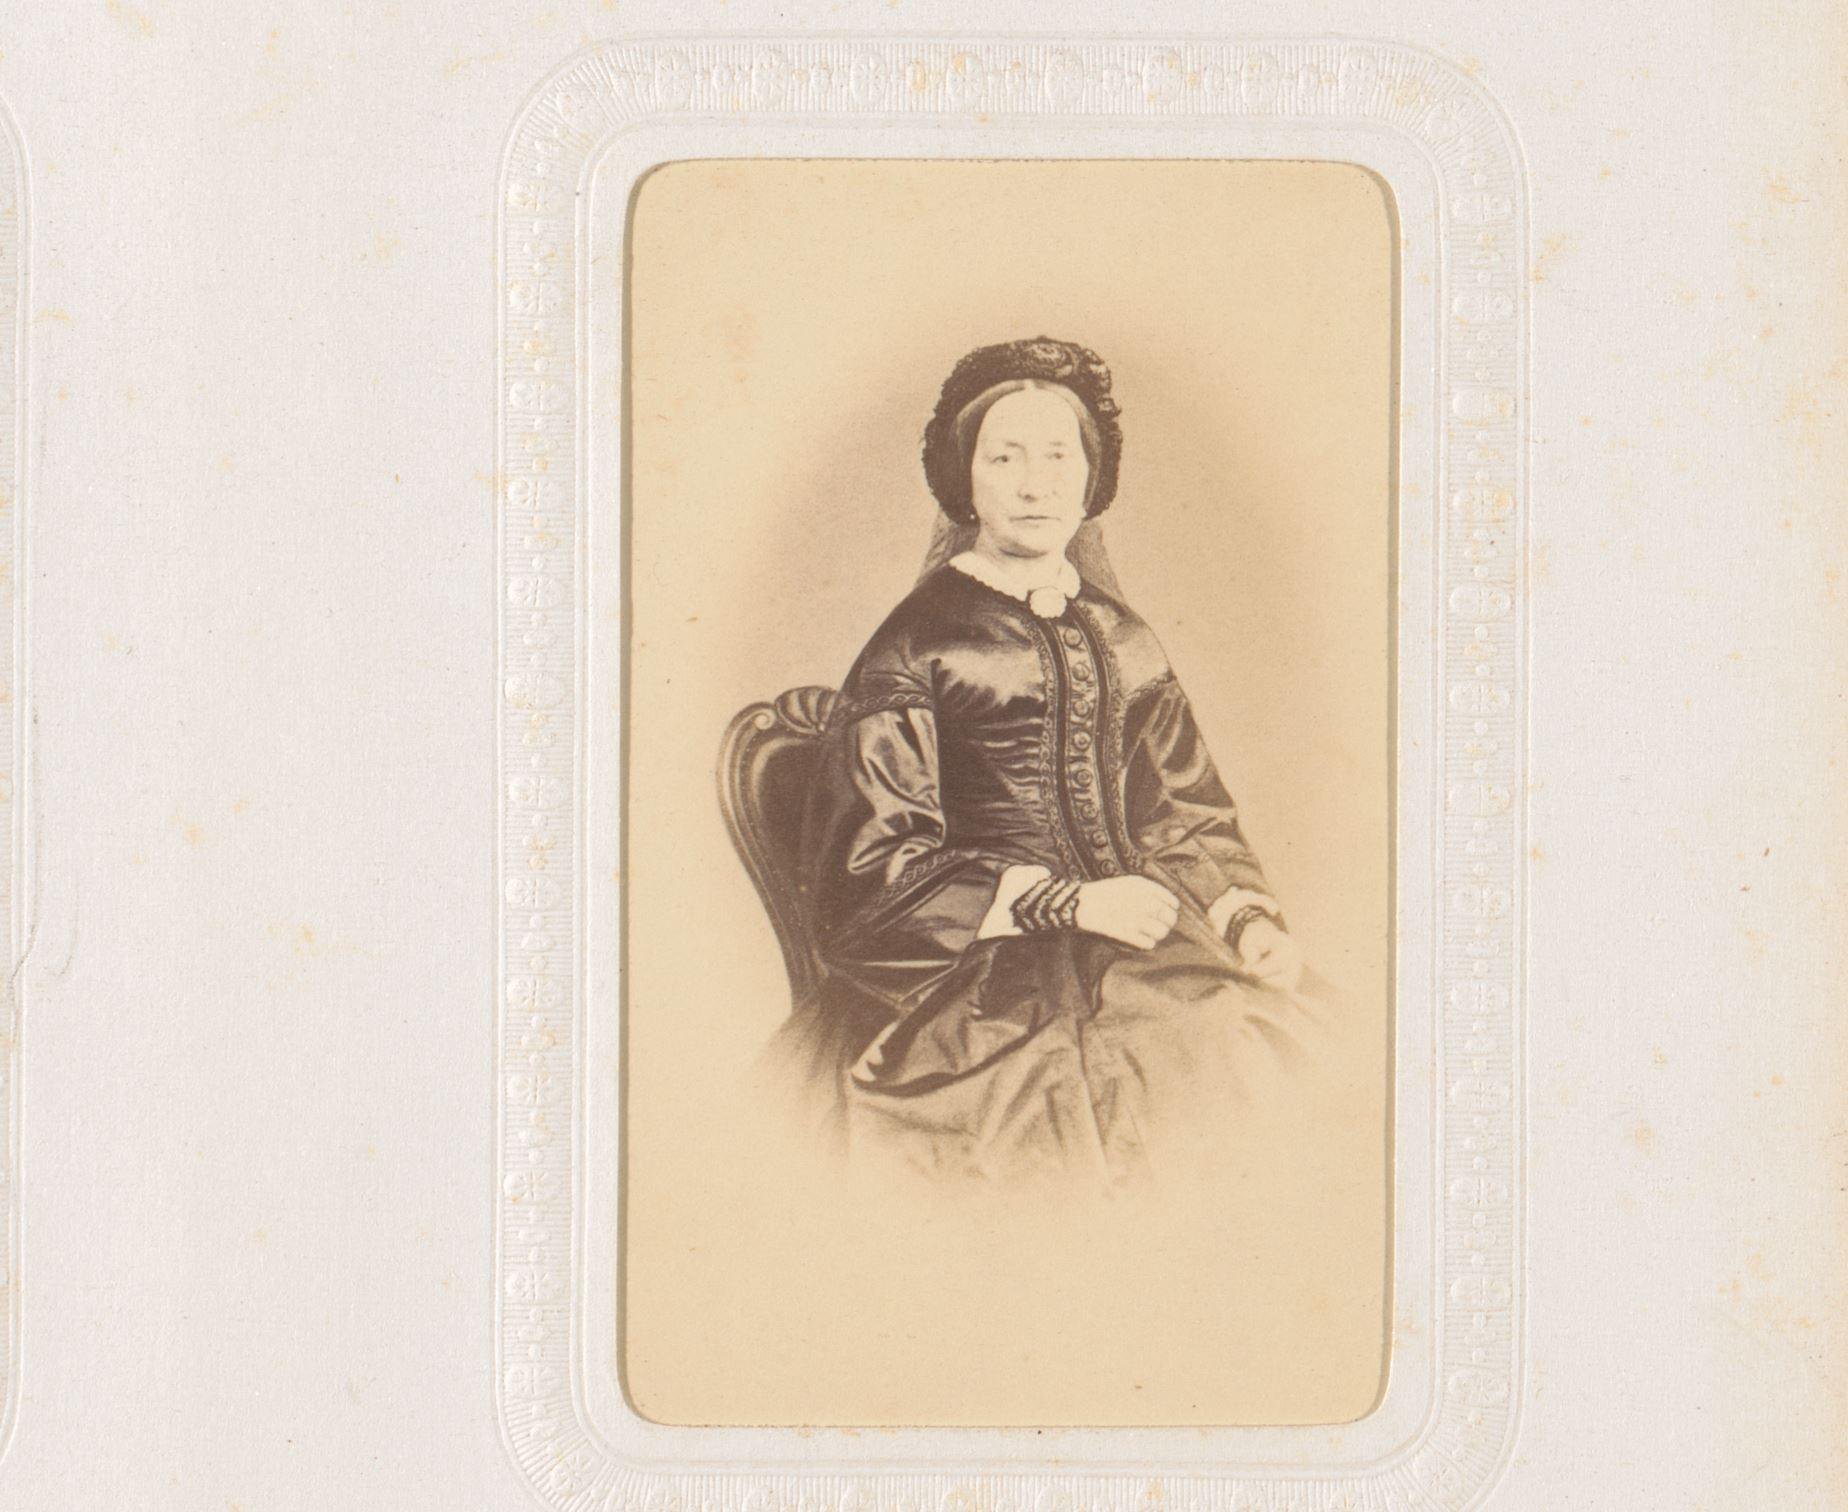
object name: carte de visite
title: Portret van een zittende oude vrouw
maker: Anonymous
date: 1850-1880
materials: cardboard, photographic support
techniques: albumen print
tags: historical persons - bb - woman, old woman